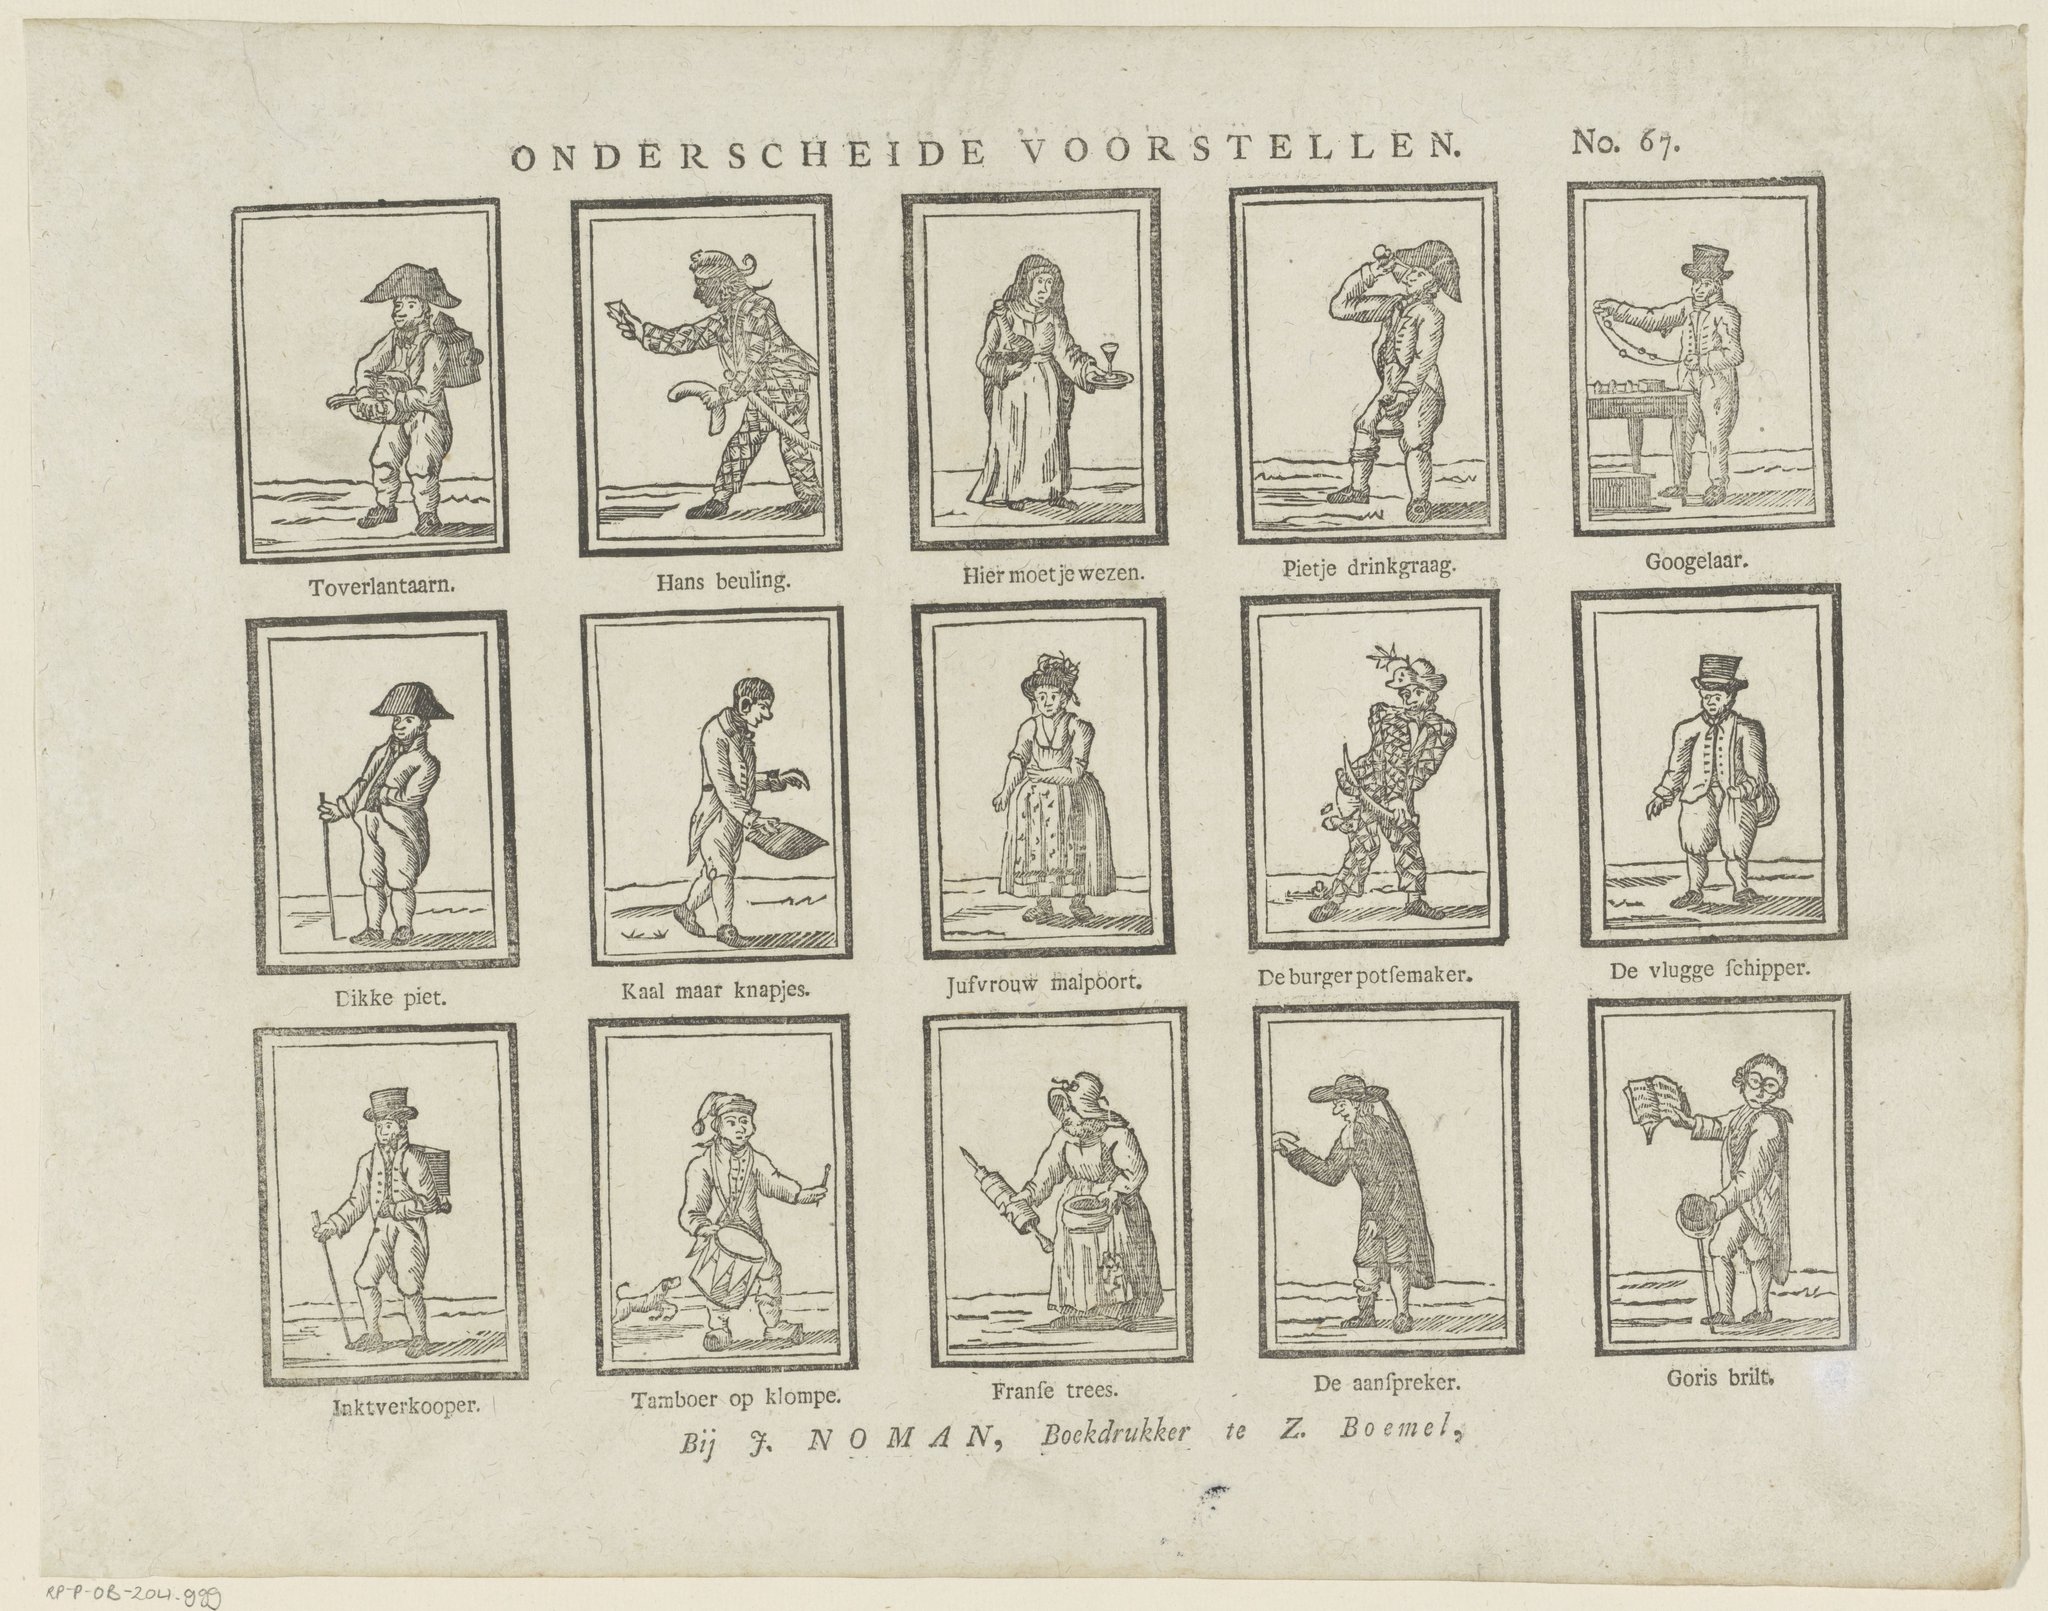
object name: print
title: Onderscheide voorstellen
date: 1806-1830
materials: paper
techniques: letterpress printing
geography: zaltbommel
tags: human types, drunkard, street-trader, drunkenness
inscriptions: collector's mark: Lugt 2760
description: Blad met 15 voorstellingen van verschillende figuren, zoals een goochelaar, een dikke man en een tamboer. Onder elke afbeelding een onderschrift. Genummerd rechtsboven: No. 67.